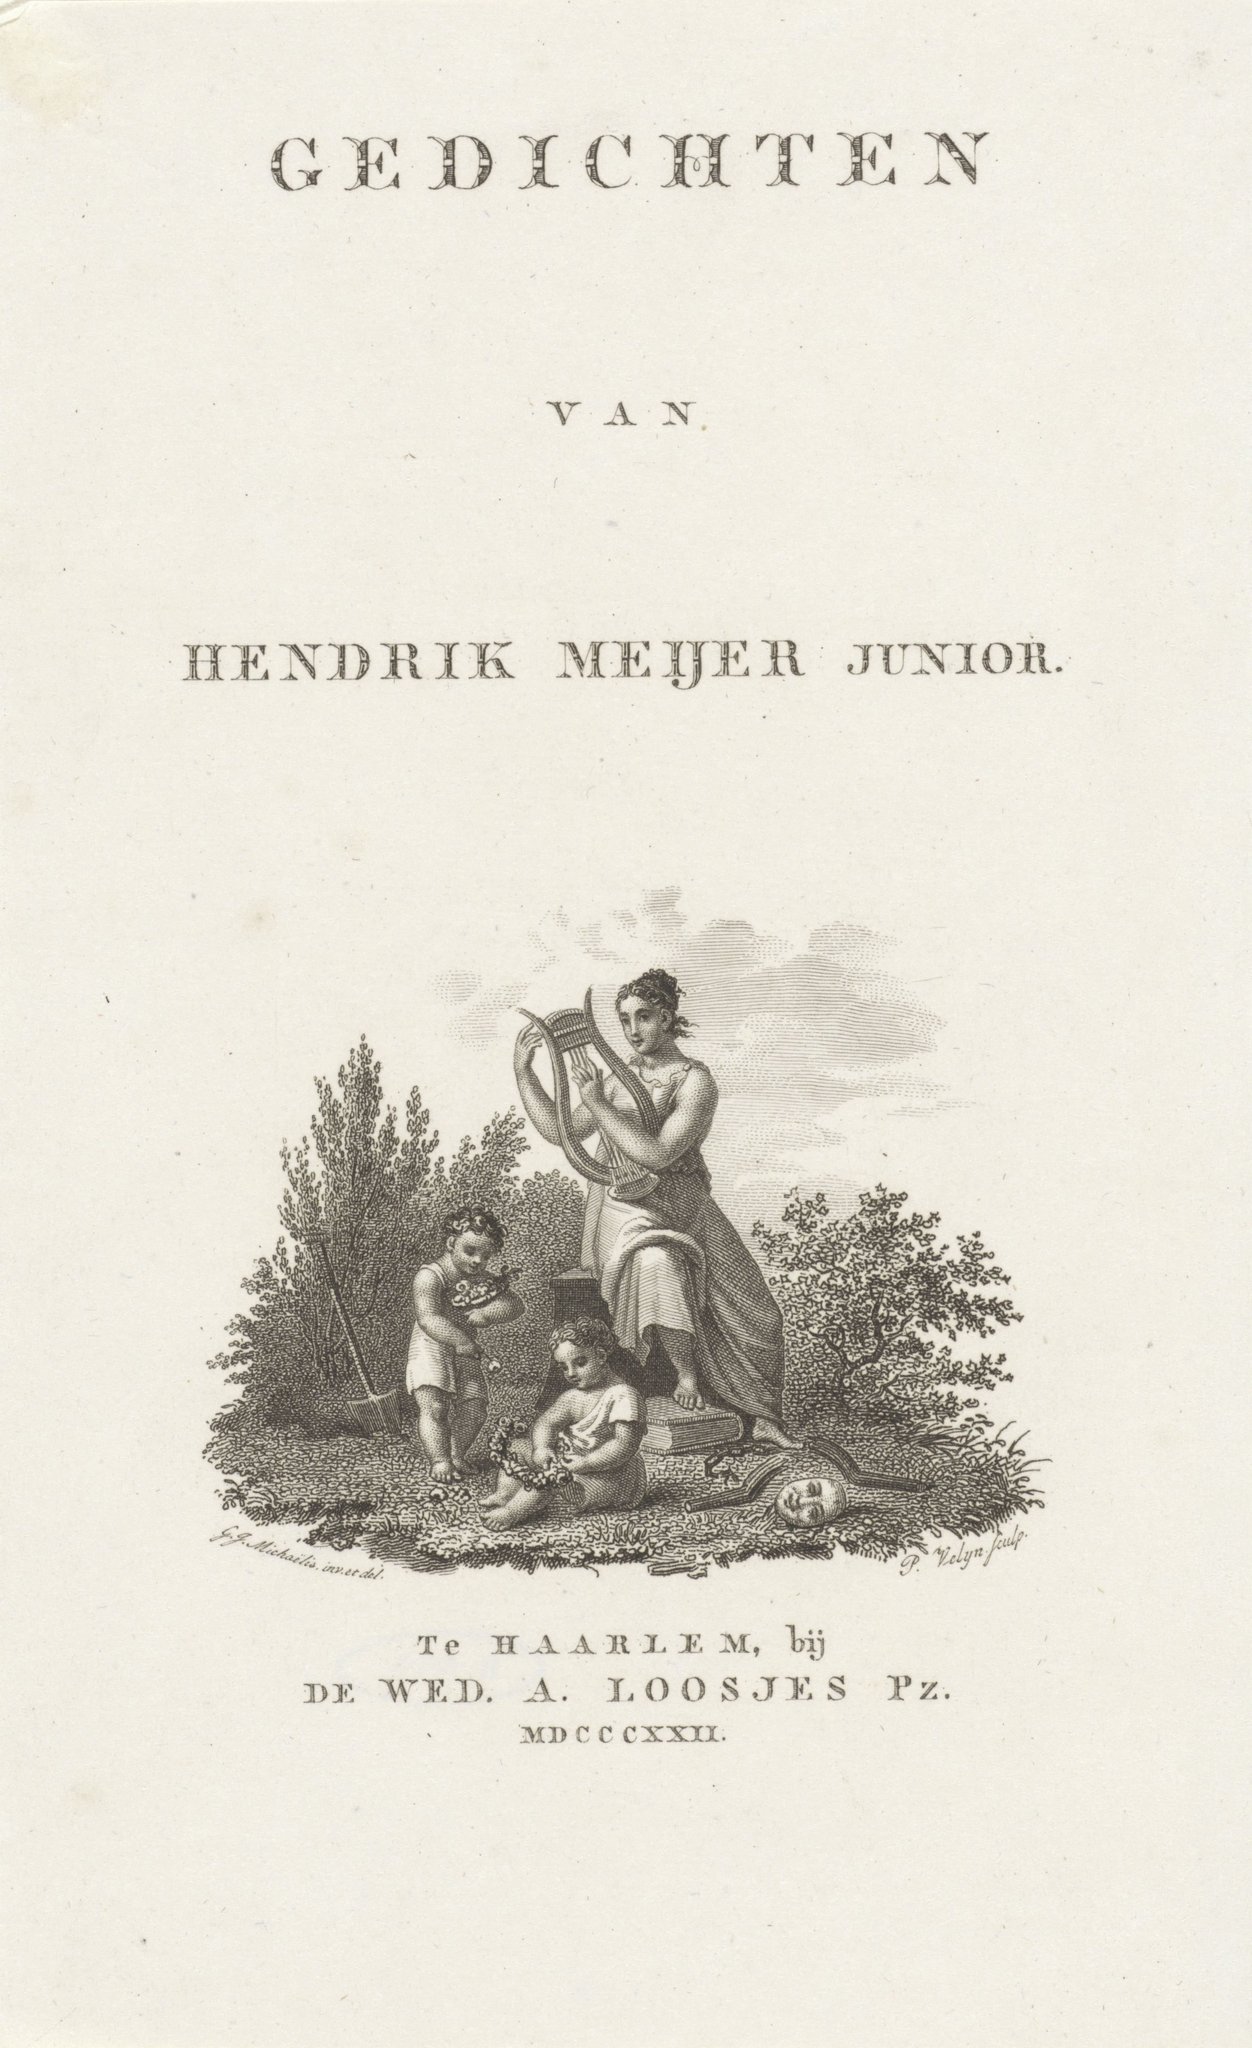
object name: titelblad, titelpagina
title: Vrouw spelend op een lier en twee spelende kinderen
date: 1822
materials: paper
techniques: engraving, etching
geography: haarlem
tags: flowers, mask, lyre, cithara, psaltery, yoke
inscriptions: collector's mark: Lugt 2228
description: Een vrouw die op een lier speelt en twee met bloemen spelende kinderen op de grond aan haar voeten. Op de voorgrond een masker en een gebroken juk.